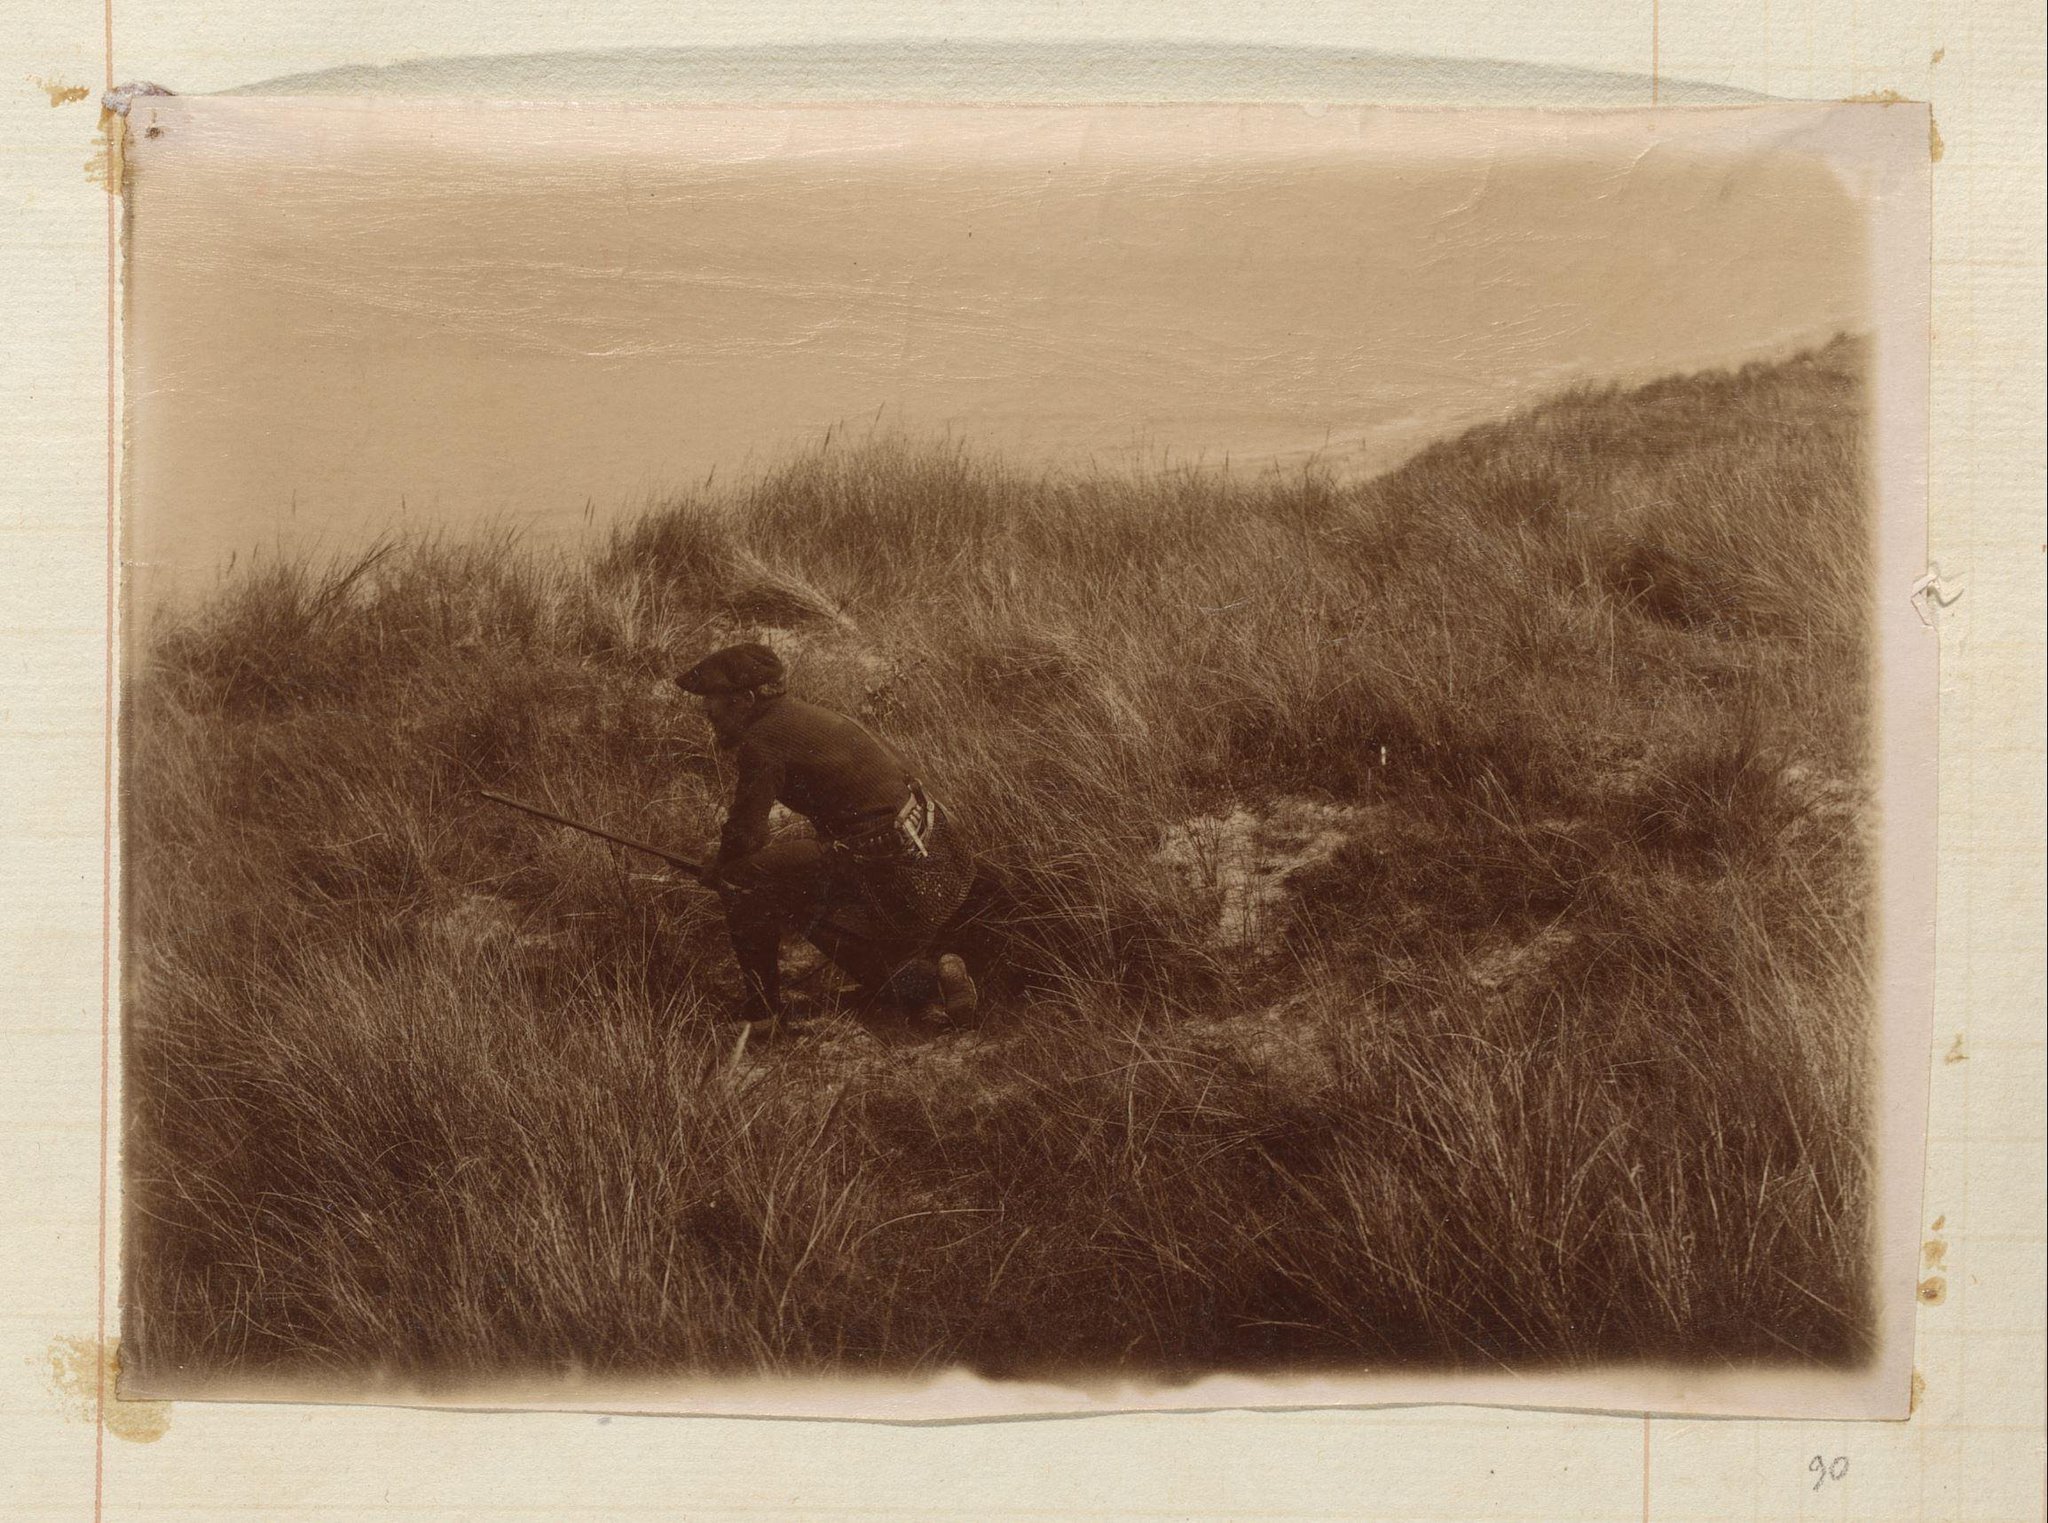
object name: photograph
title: Jager in de duinen, gebukt zittend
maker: Anonymous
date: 1880-1900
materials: paper, photographic support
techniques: albumen print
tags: dune coast, hunting, chase